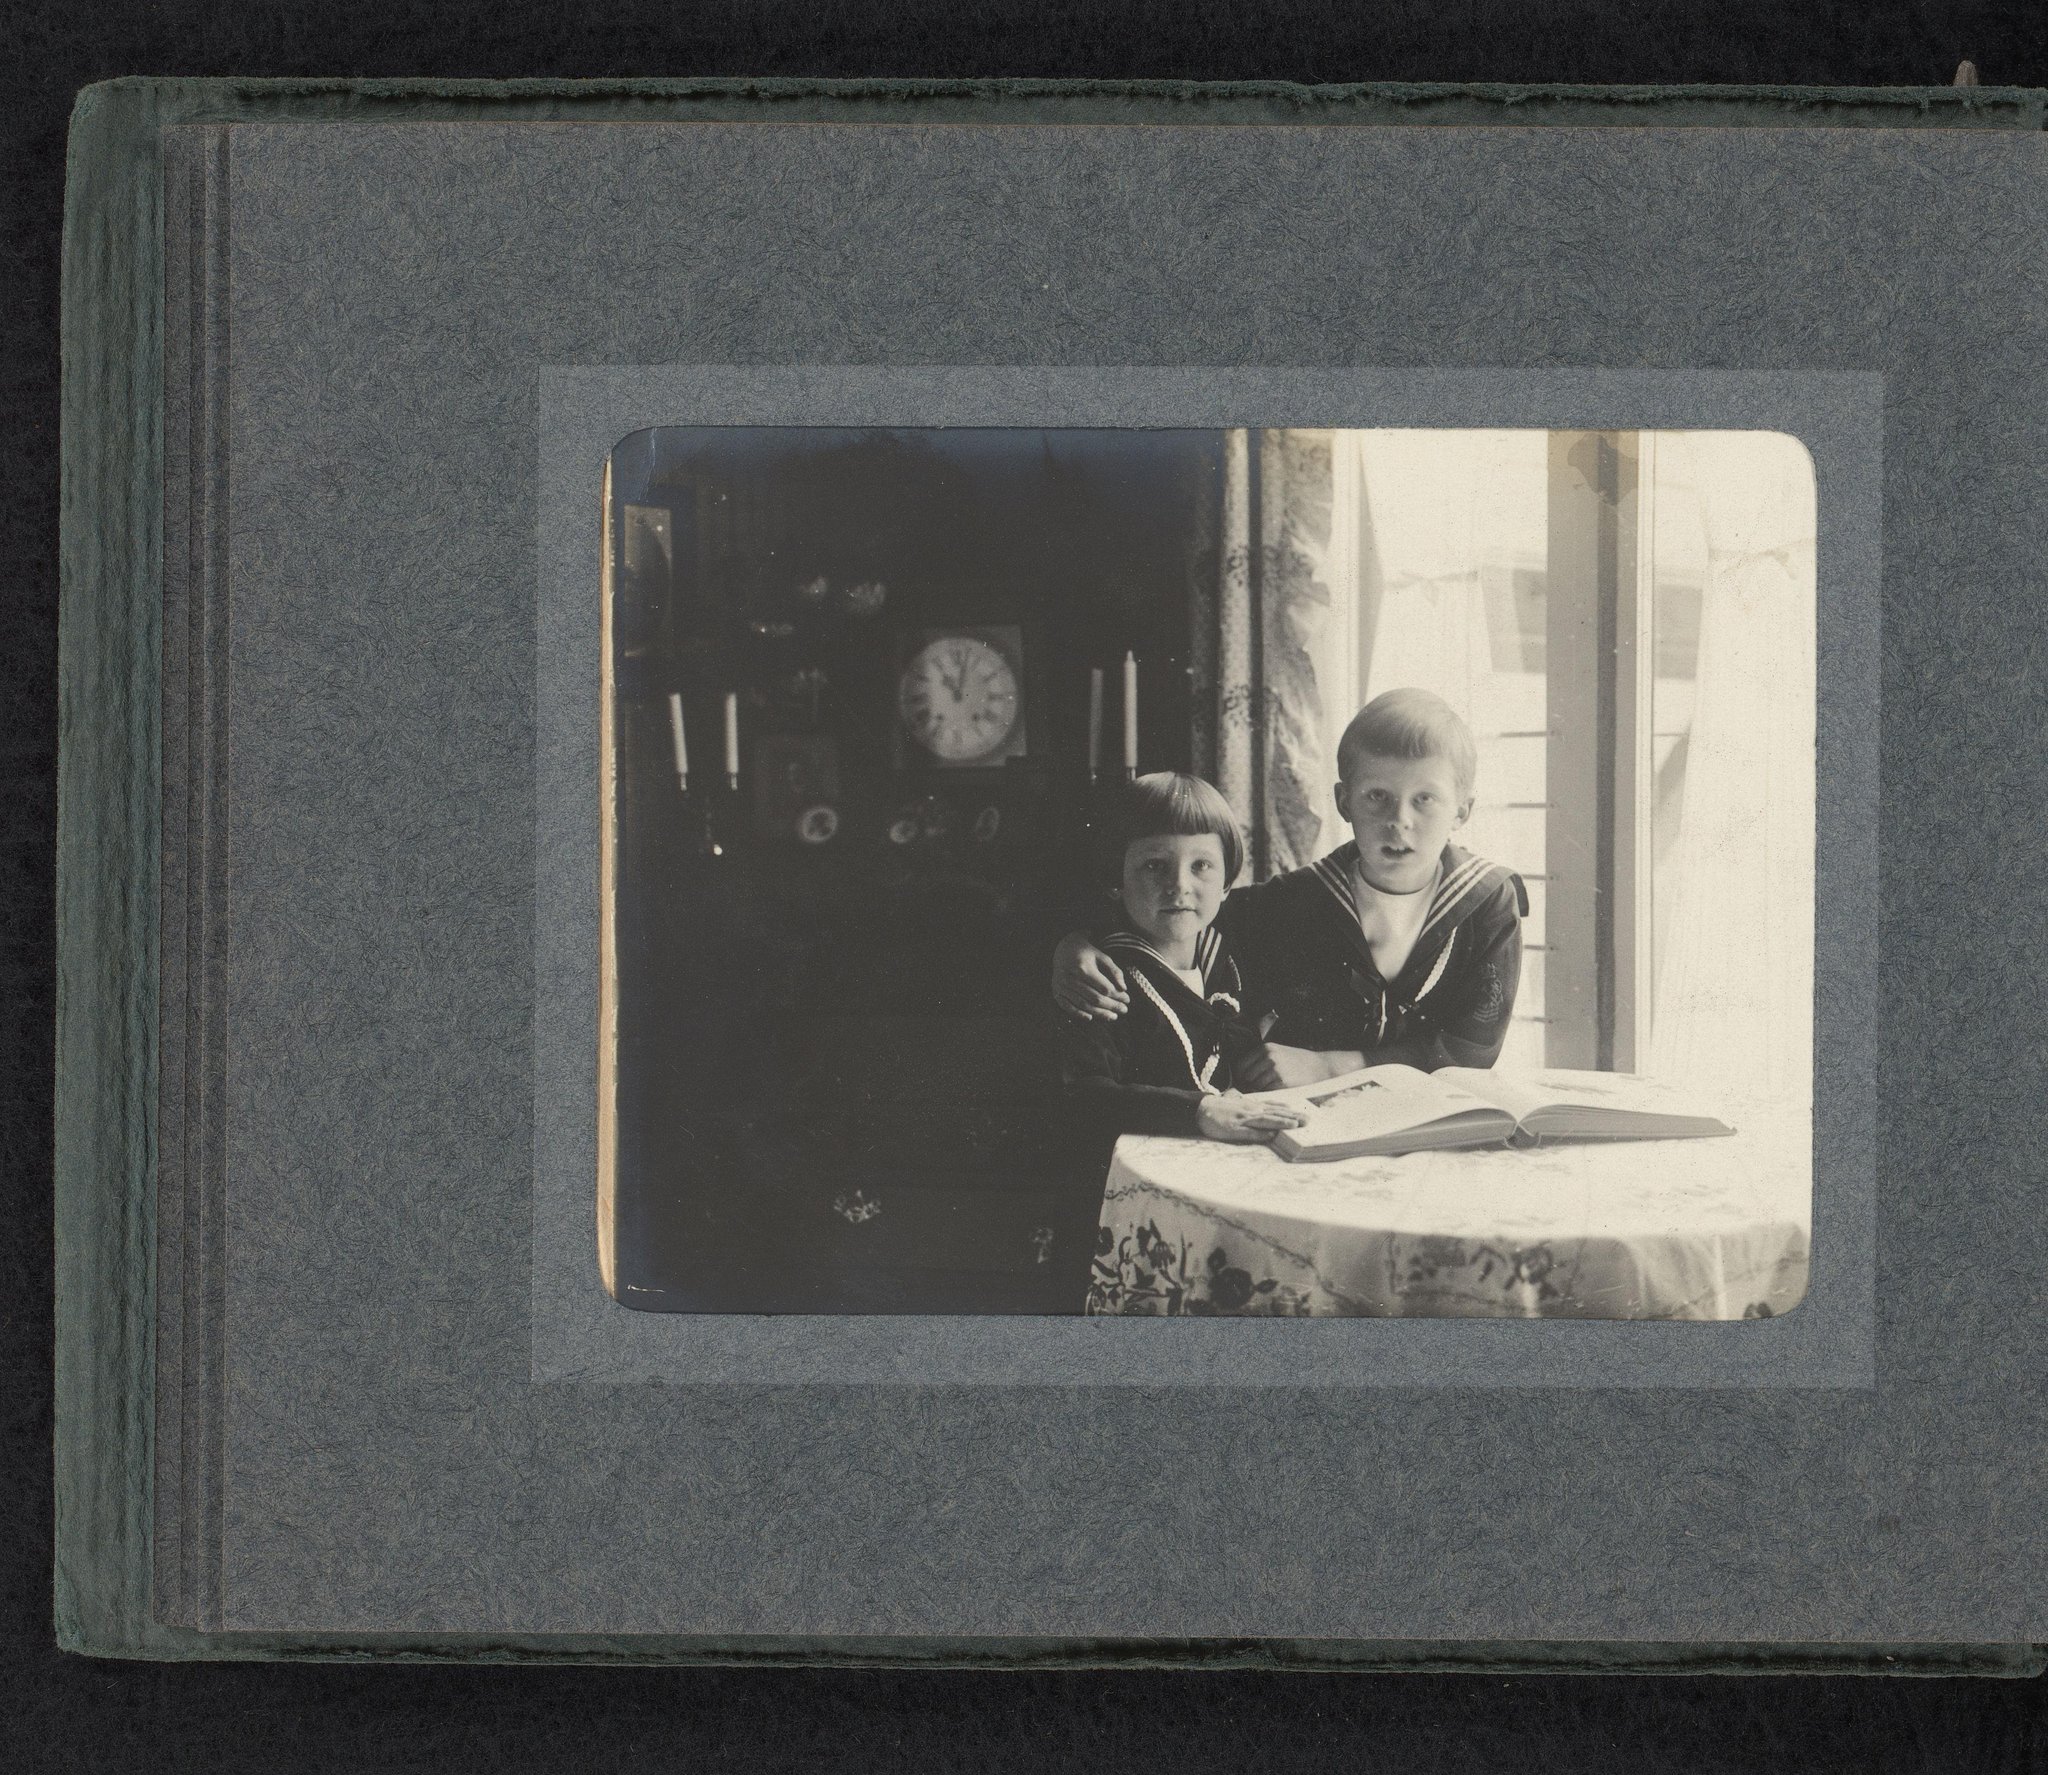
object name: photograph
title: Carel en Frank van den Berg bij een fotoalbum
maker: hendrik herman van den berg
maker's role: amateurfotograaf, jurist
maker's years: 1875-1944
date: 1918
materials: paper, cardboard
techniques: gelatin silver print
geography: amsterdam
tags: amsterdam, carel frederik van den berg (cay), frank willem van den berg (1912-1998), book - mm - book open